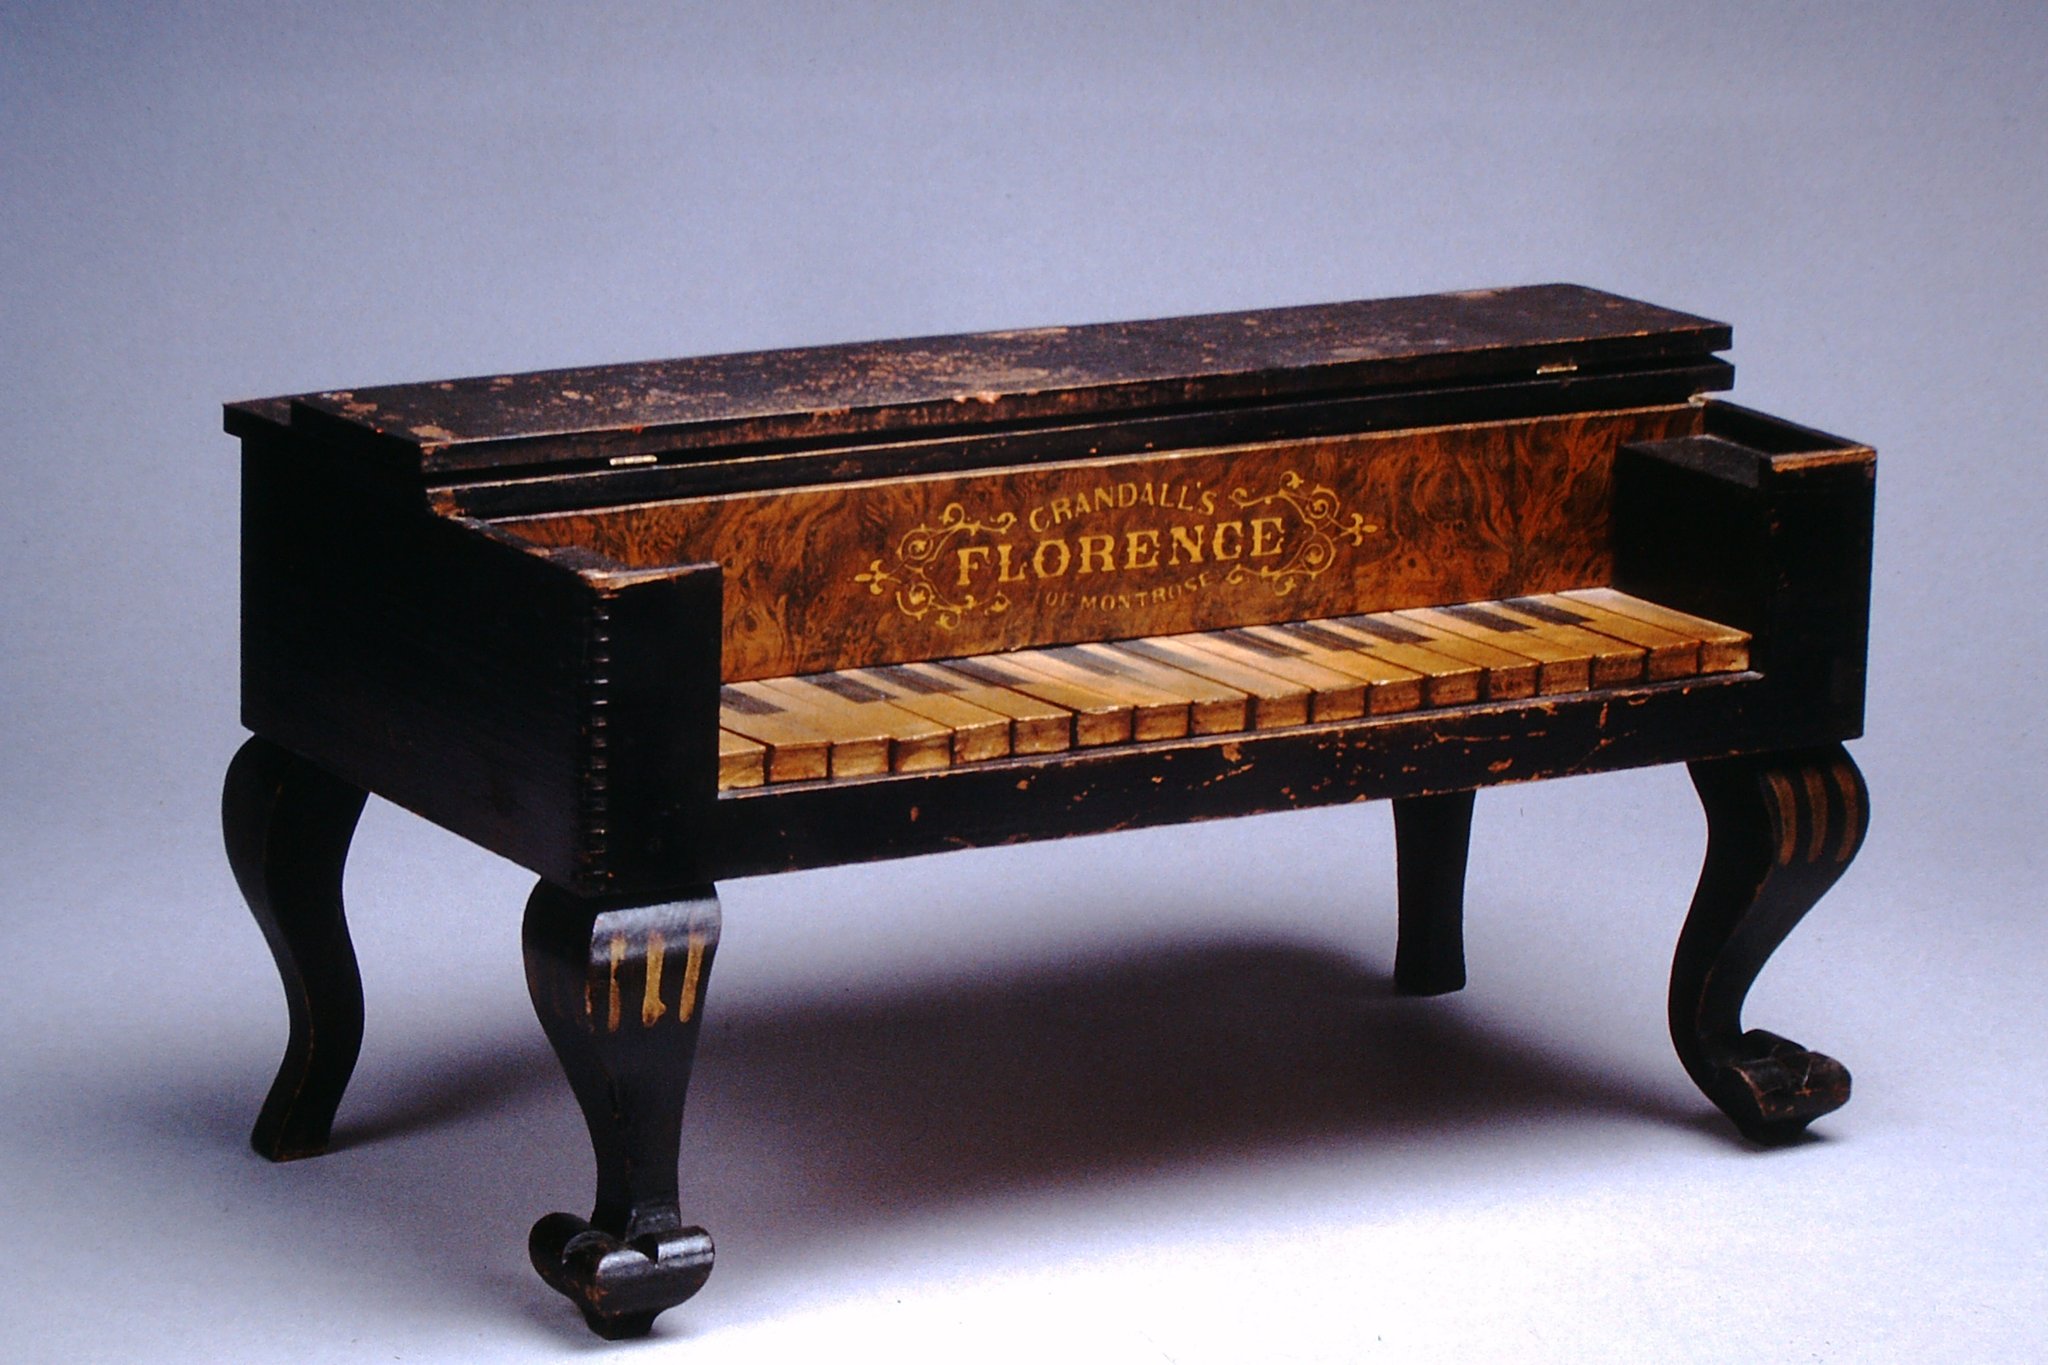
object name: toy square piano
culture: american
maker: charles martin crandall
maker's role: maker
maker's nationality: american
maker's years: 1833-1905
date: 1860-1880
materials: metal, wood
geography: united states